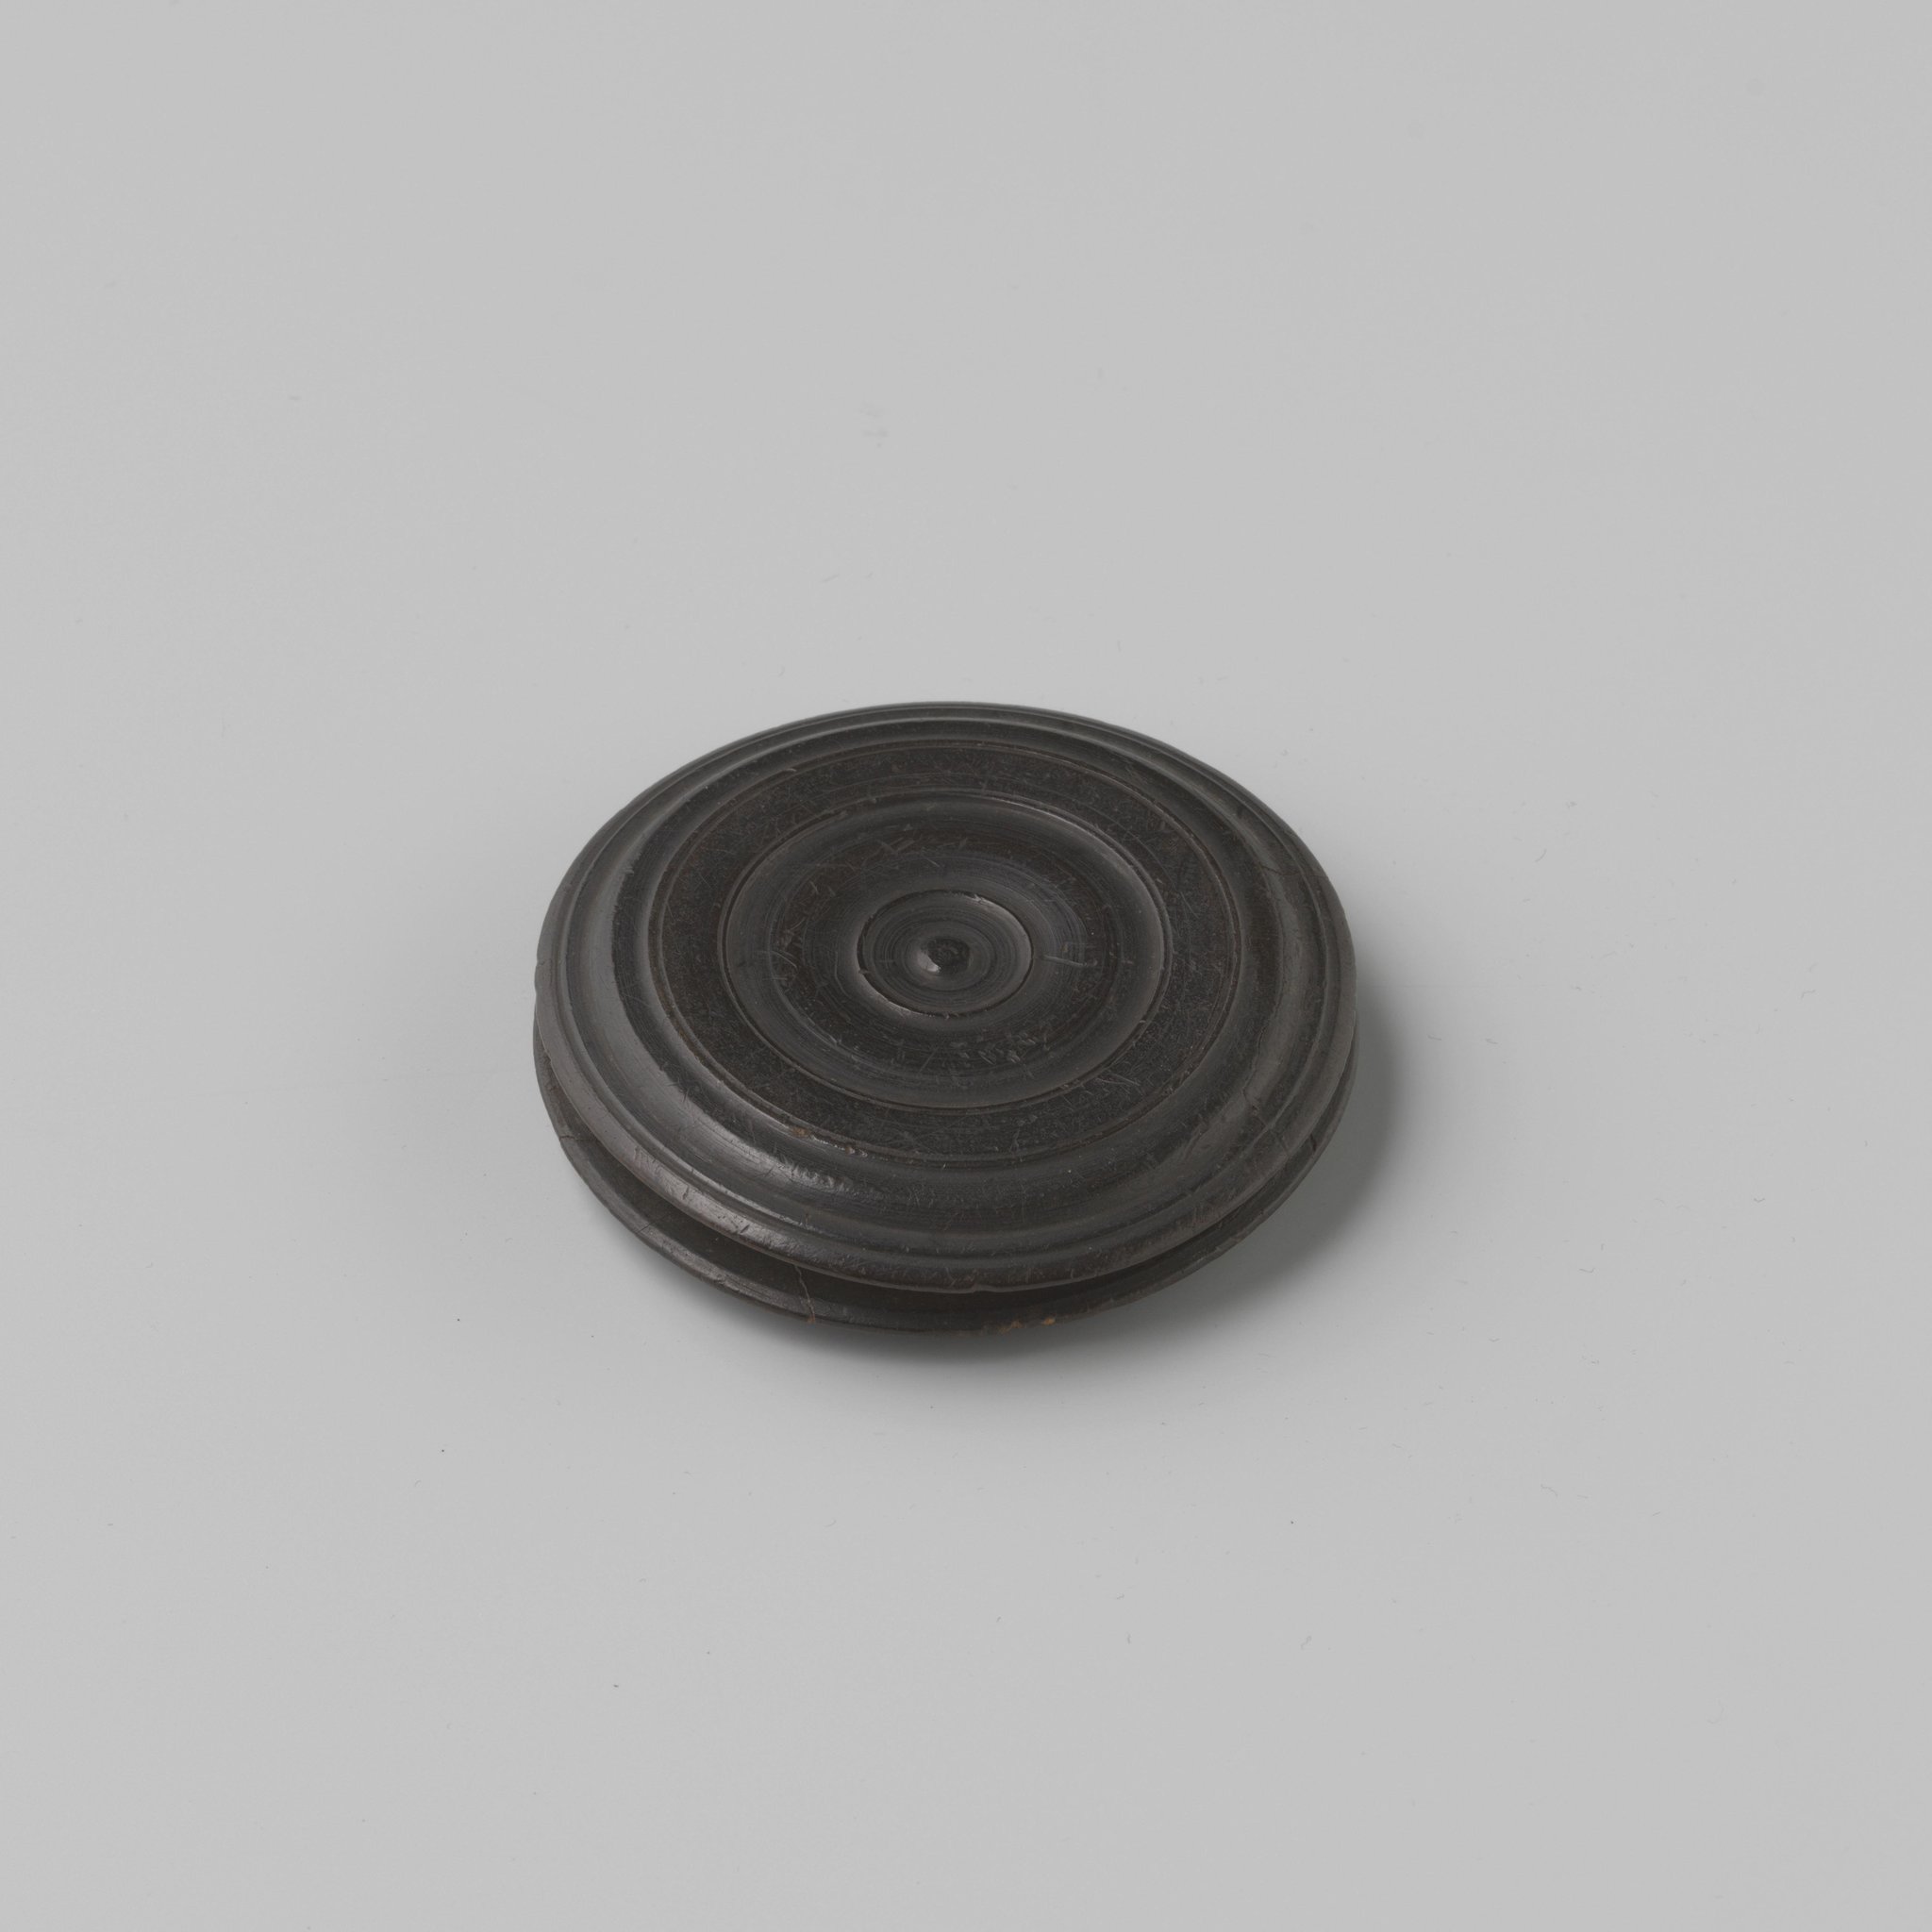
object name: history medal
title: Doos voor een penning op het overlijden van stadhouder Willem II 1650 met ingeplakte gedichten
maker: joost van den vondel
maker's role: dichter, toneelschrijver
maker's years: 1587-1679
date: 1650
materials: wood, paper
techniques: turning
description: Gedraaide palmhouten doos met deksel, beide van binnen voorzien van een gedrukt gedicht, op de doos "Overval" en op de deksel "Afval".